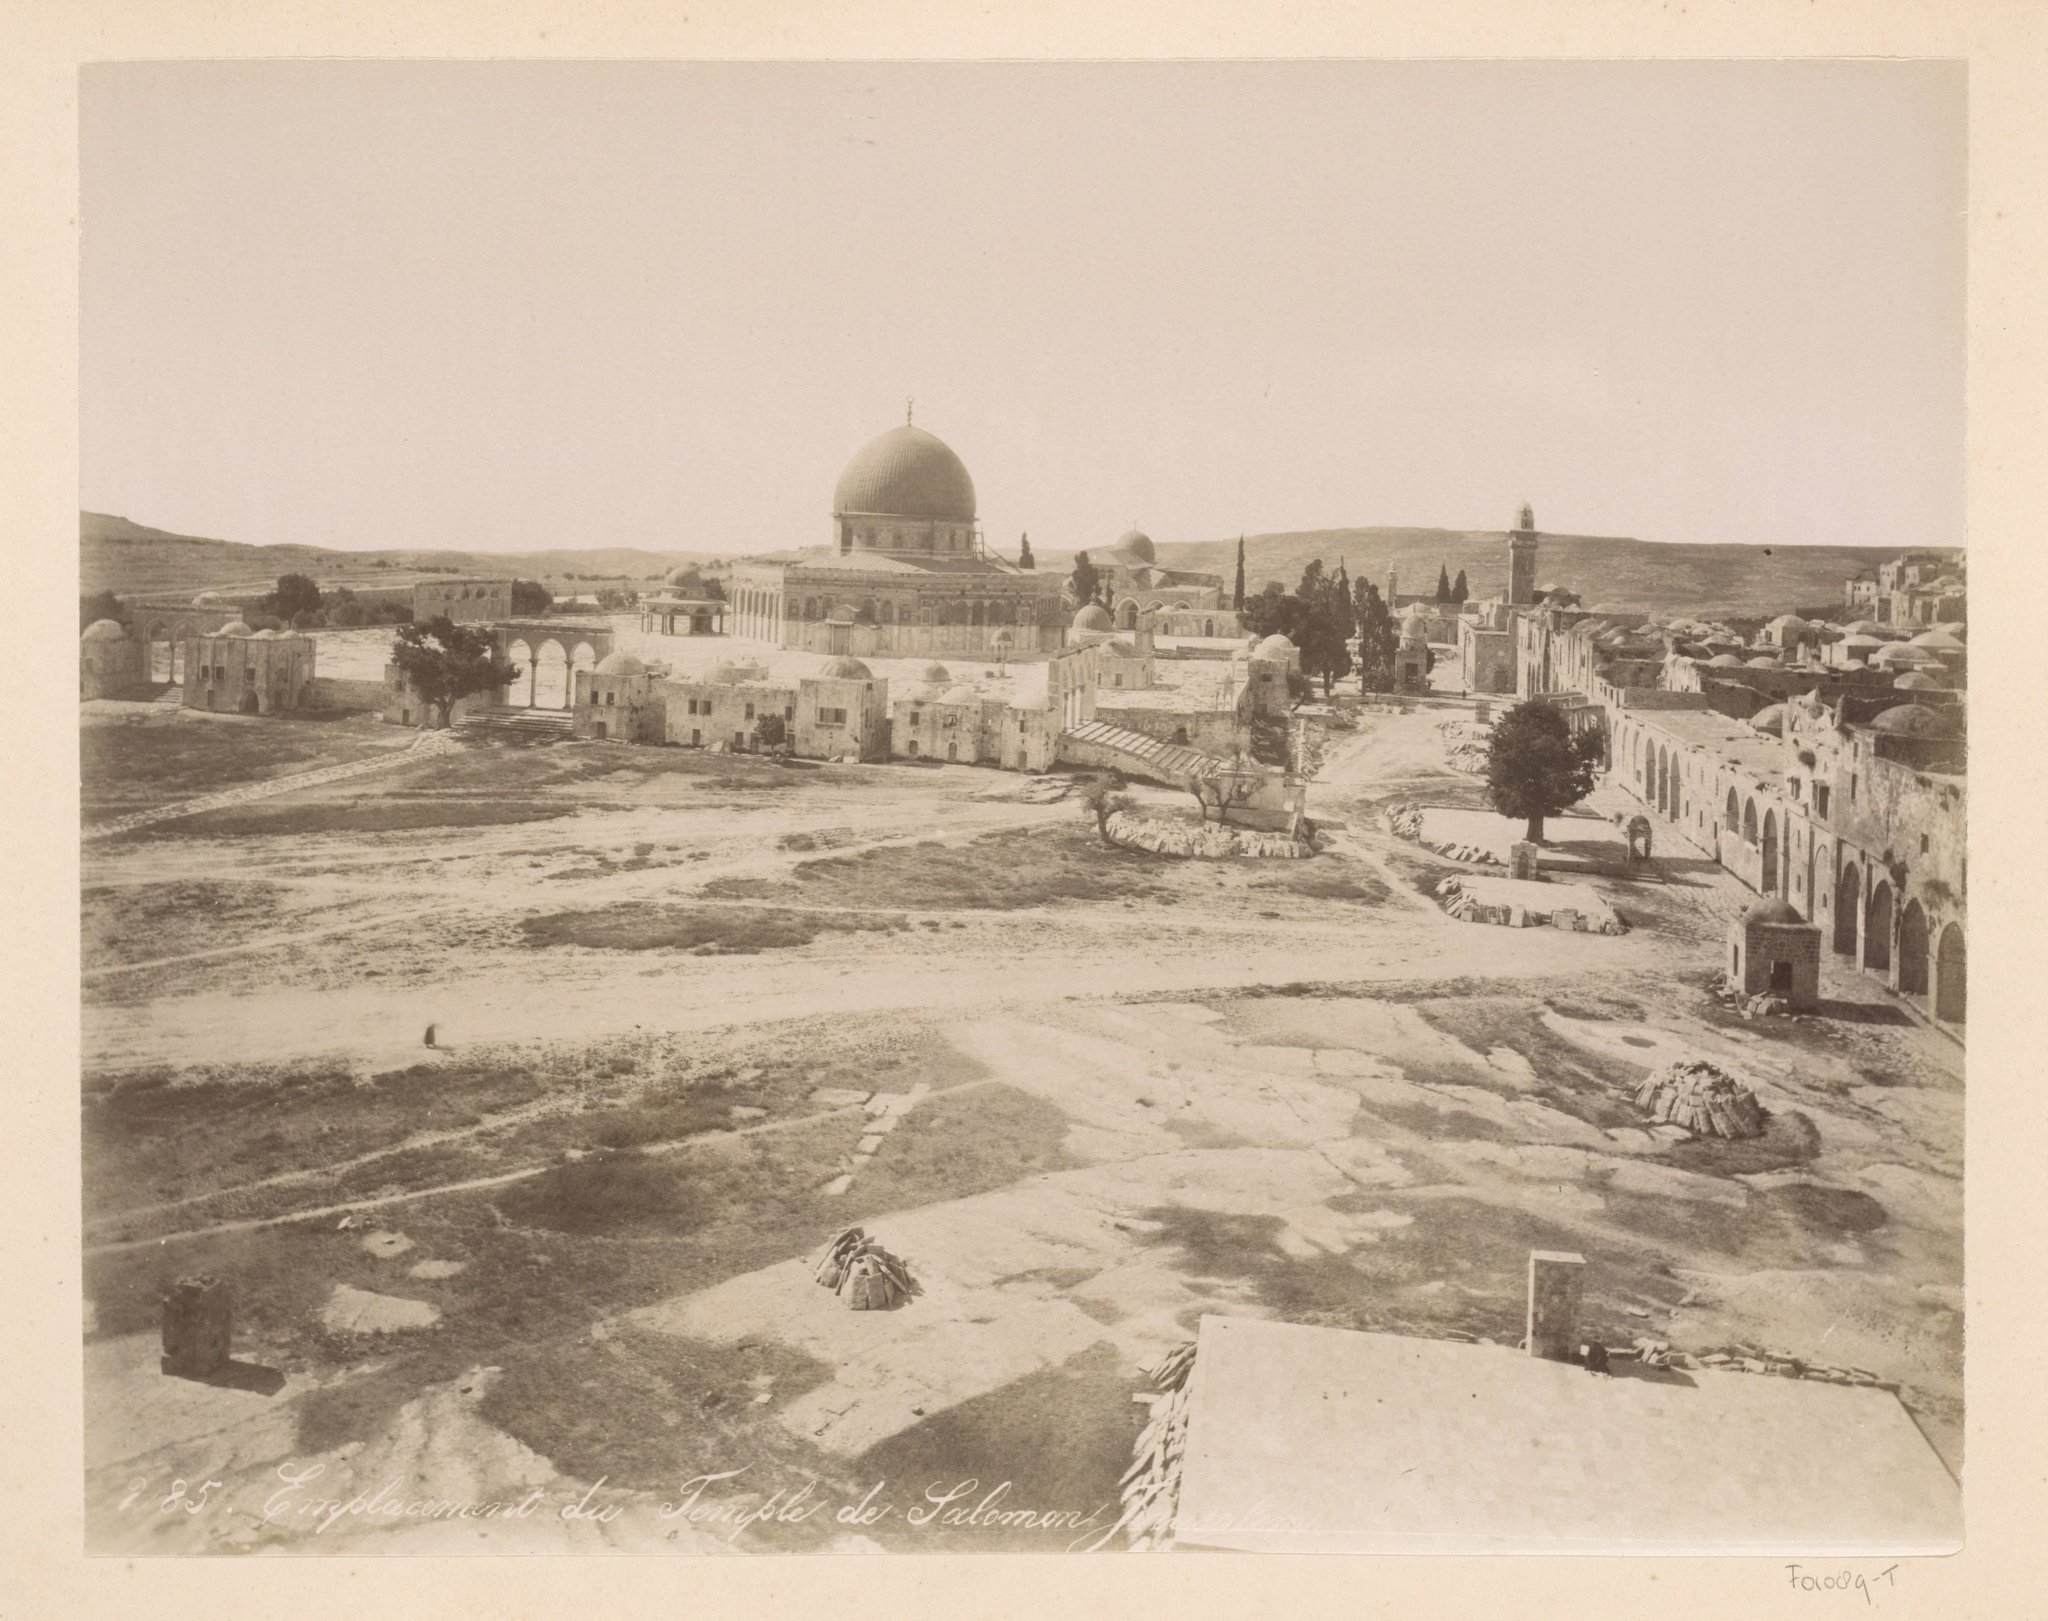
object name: photograph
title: Emplacement du Temple de Salomon Jerusalem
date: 1867-1895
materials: cardboard, paper, photographic support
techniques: albumen print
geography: jerusalem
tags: temple, shrine ~ islam, mohammedanism, temple of solomon (1 kings 5-9; 2 chronicles 2-7)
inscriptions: negative number: ‘285’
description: Onderdeel van Reisalbum met foto's van Jeruzalem en andere bijbelse plaatsen.